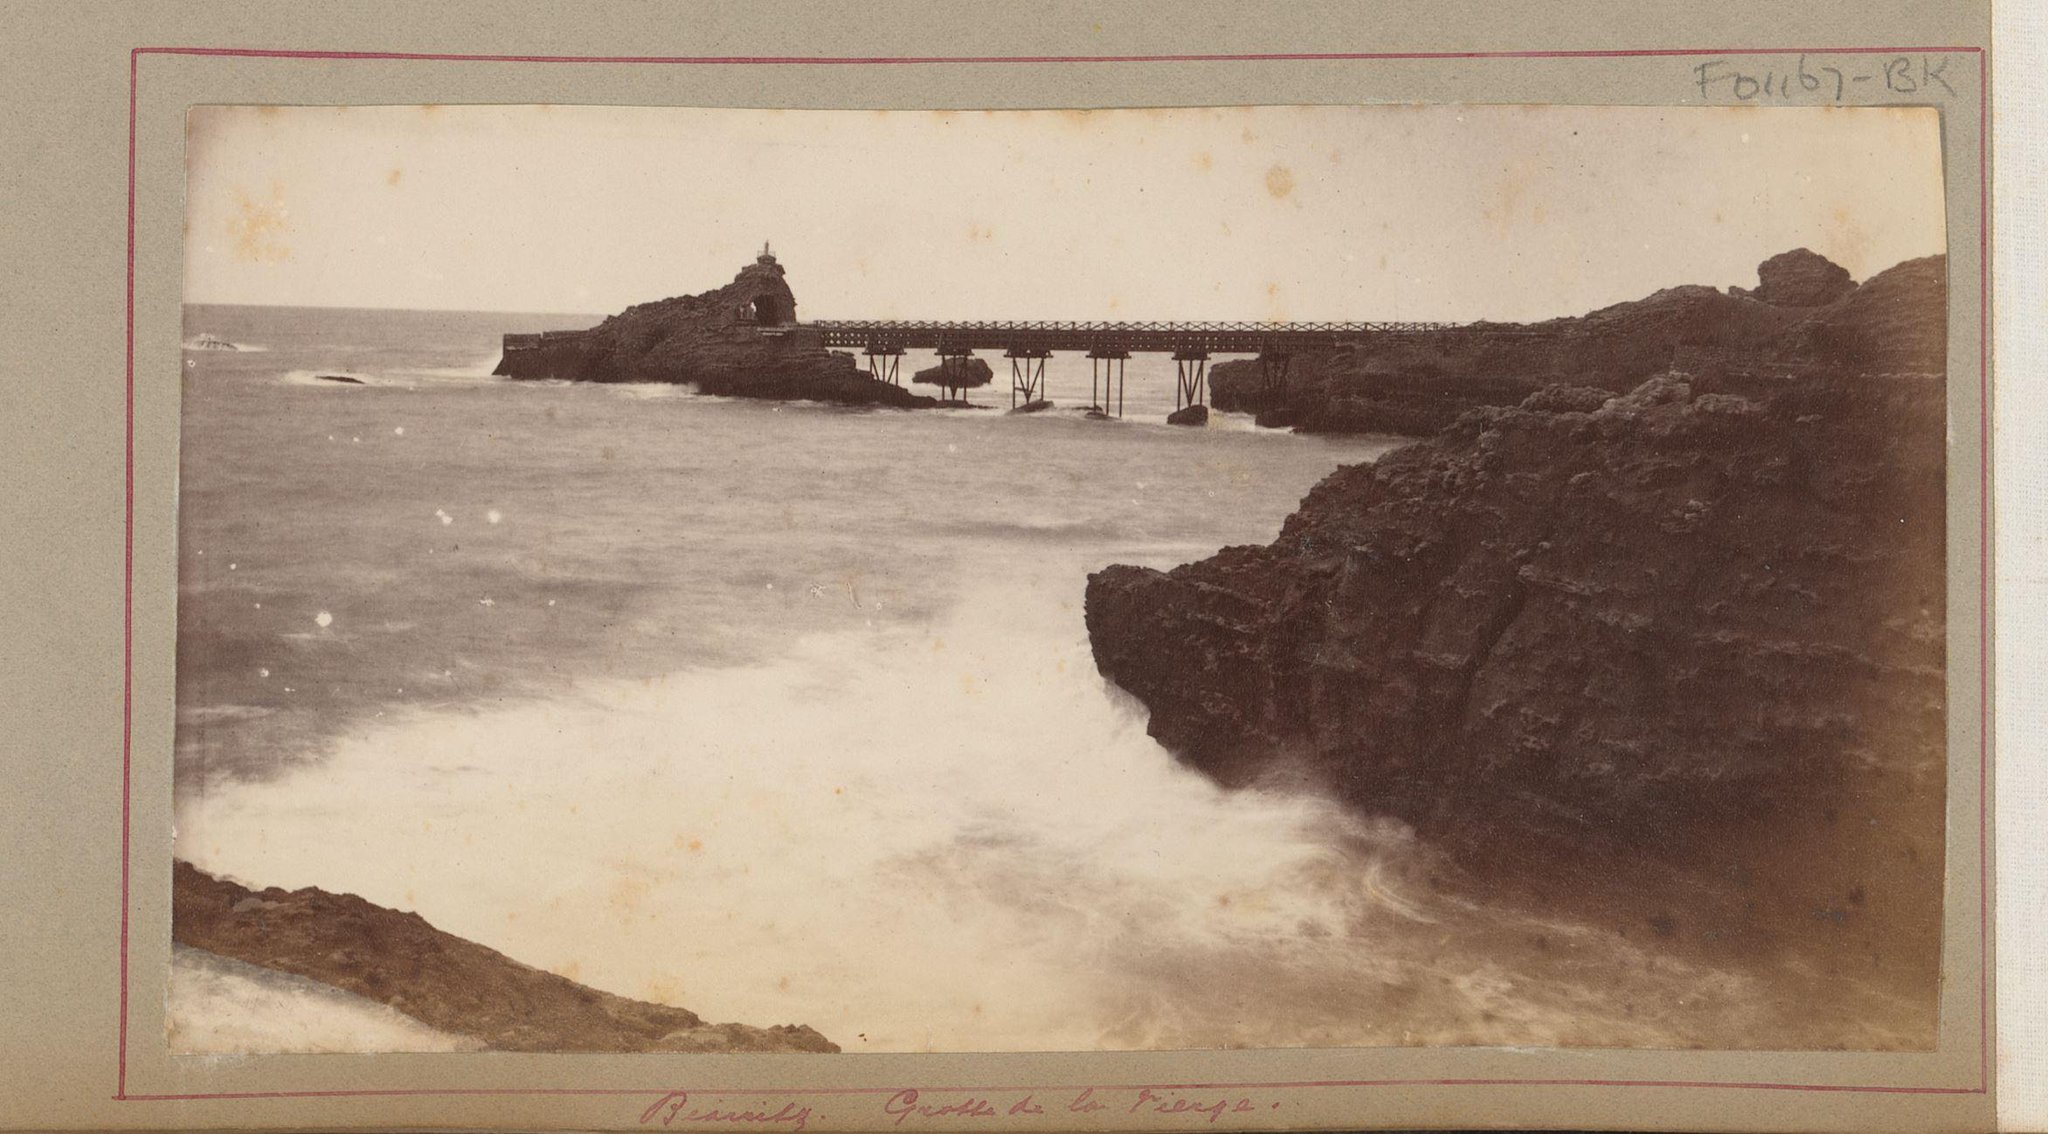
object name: album leaf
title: Gezicht op Rocher de la Vierge te Biarritz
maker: Anonymous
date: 1880-1910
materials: photographic support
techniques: albumen print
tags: rocky coast, sea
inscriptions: annotation: ‘Biarritz; Grotte de la Vierge’